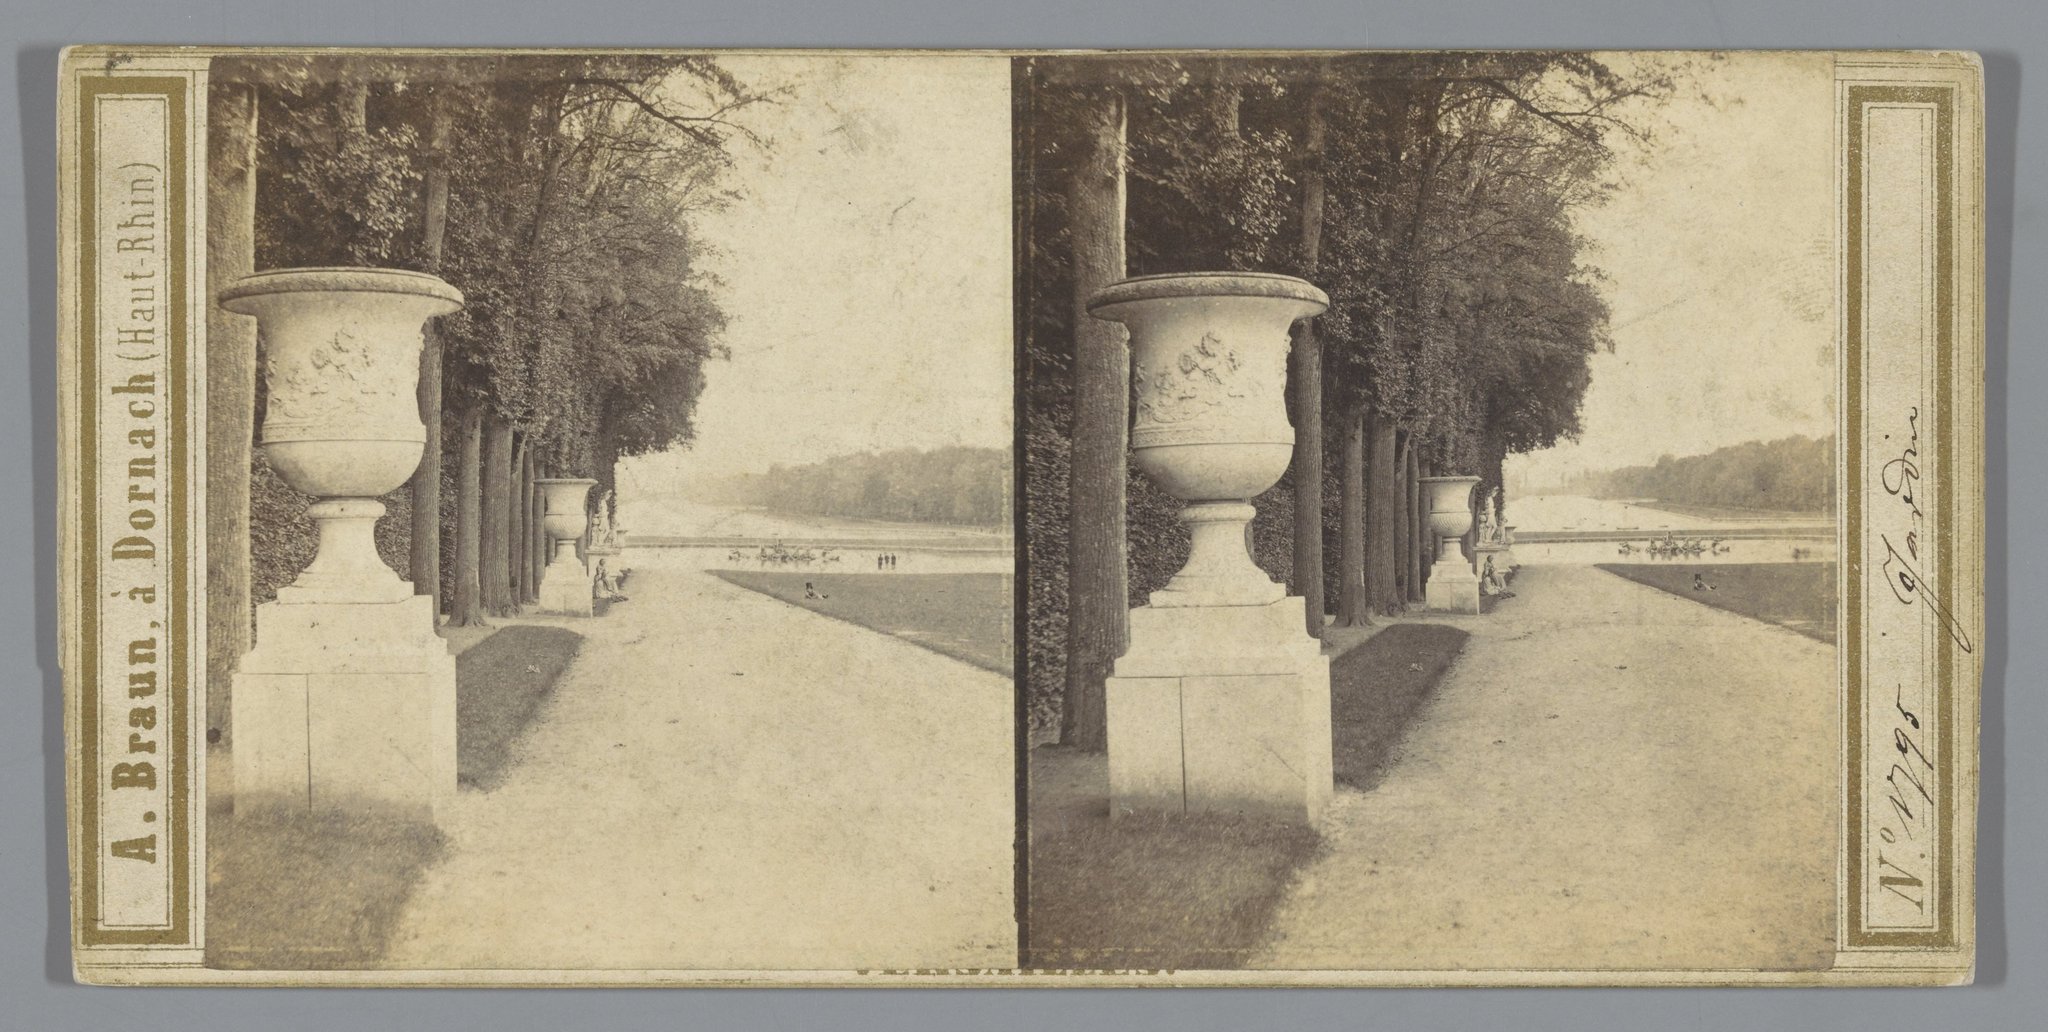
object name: stereograph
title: Laan in het park van Versailles, met tuinvazen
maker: Anonymous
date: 1860-1866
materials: cardboard, paper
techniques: albumen print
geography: versailles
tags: french or architectonic garden; formal garden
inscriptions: inscription: ‘300-’, number: ‘No. 1795’